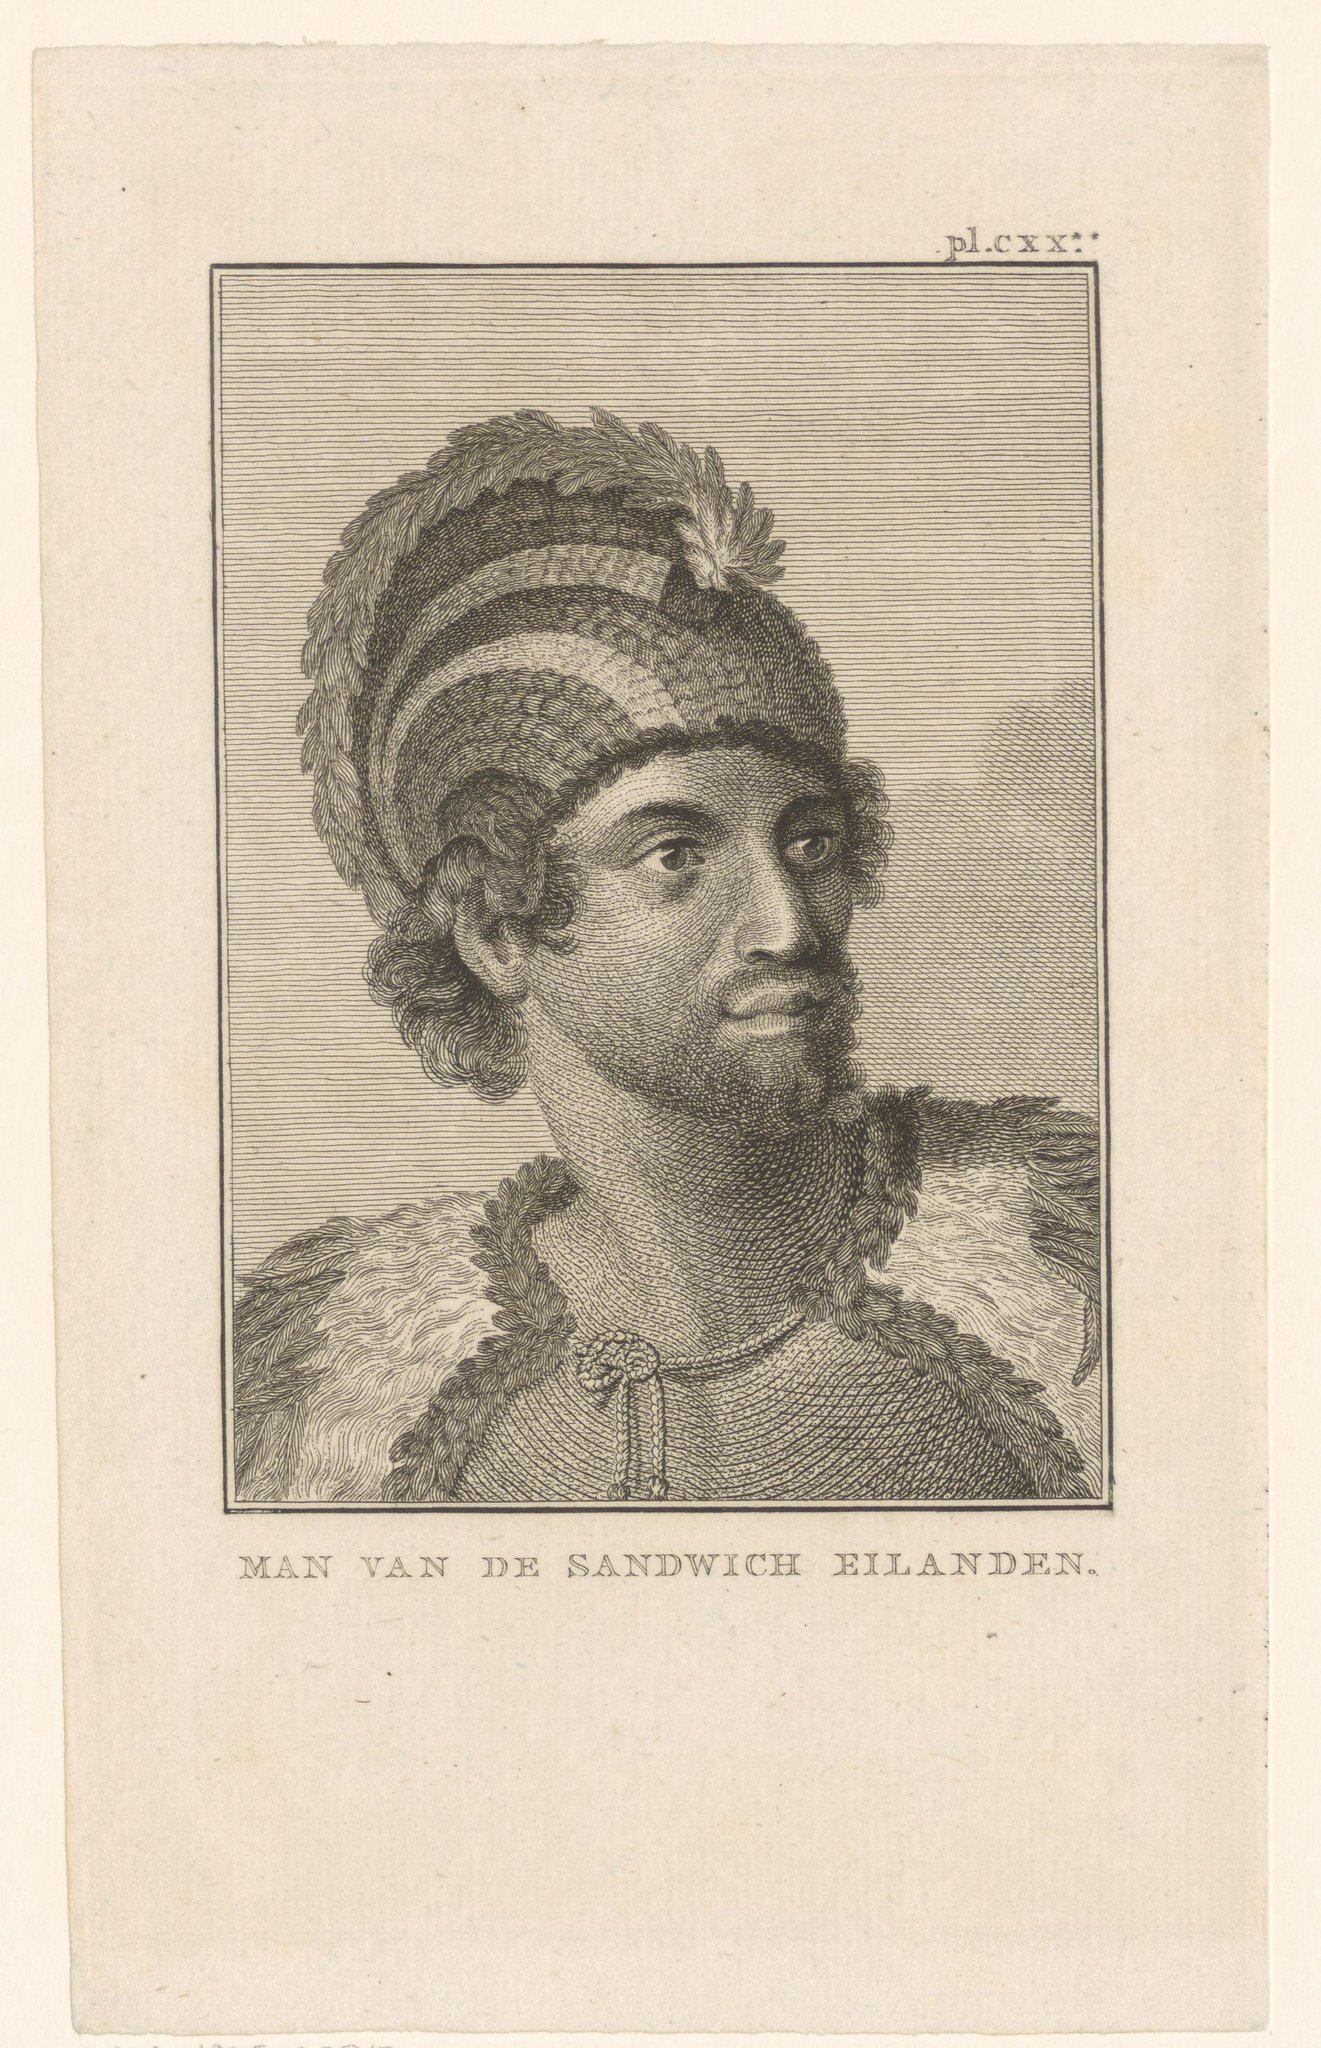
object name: book illustration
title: Portret van een onbekende man afkomstig van de Sandwicheilanden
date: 1795-1803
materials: paper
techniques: engraving, etching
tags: adult man, anonymous historical person portrayed, folk costume, regional costume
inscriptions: collector's mark: Lugt 2228, number: ‘CXX’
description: De prent is gebruikt in: Cook, James. Reize rondom de Waereld (...) met kaarten en plaaten. [Vertaald uit het Engels door] Jan David Pasteur. Leiden: Honkoop, Amsterdam: Allart, Den Haag: Van Cleef, 1795-1803, dl. 13.